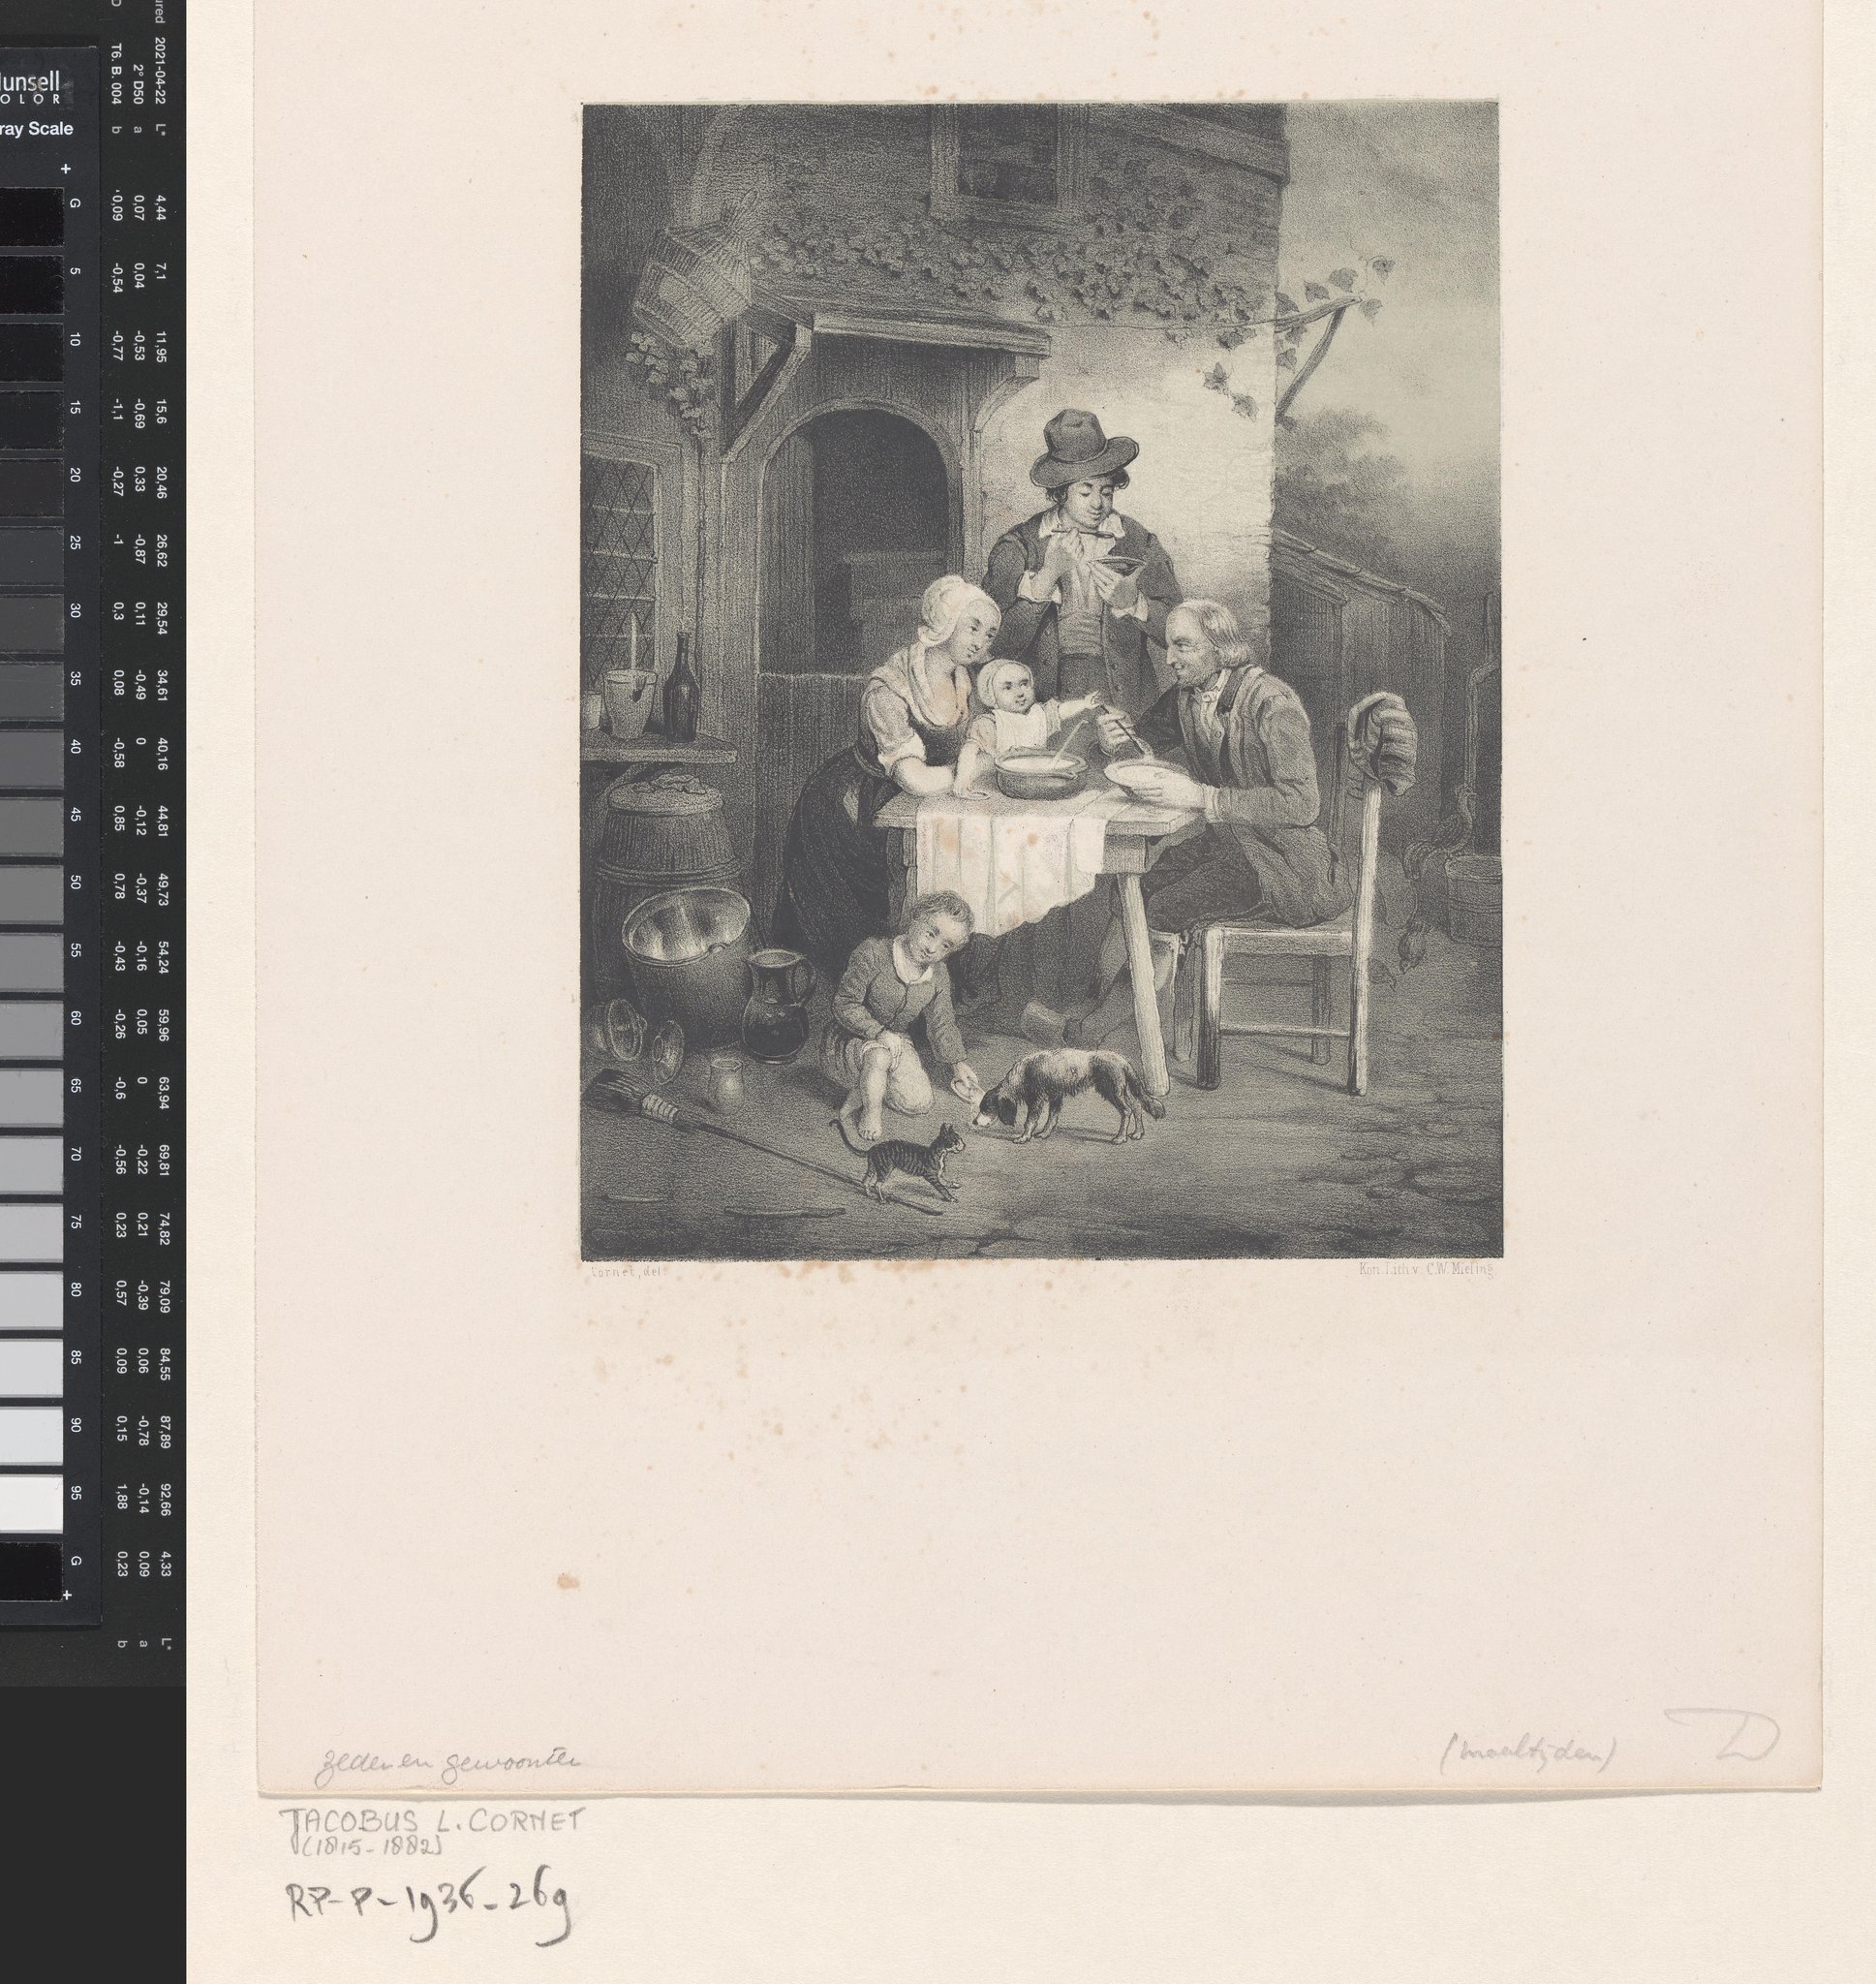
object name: print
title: Familie buiten aan tafel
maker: jacobus ludovicus cornet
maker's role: draughtsman, print maker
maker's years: 1815-1882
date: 1847-1865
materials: paper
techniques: tone lithography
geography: the hague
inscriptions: stamp: ‘Waller’ 2760, collector's mark: Lugt 2228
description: Een man en vrouw zitten aan tafel. De vrouw heeft een klein kind op schoot, de man eet soep. Naast hen staat een man met een hoed op, hij eet ook van de soep. Op de grond zit een jongen die zijn soep aan een hond geeft. Het gezelschap zit buiten voor een huis. De deur is half geopend, er groeit klimop tegen de muur en er staan en liggen allerhande spullen zoals een bezem, een ton en een karaf. Op het erf zijn verder een kat, een haan en kippen.